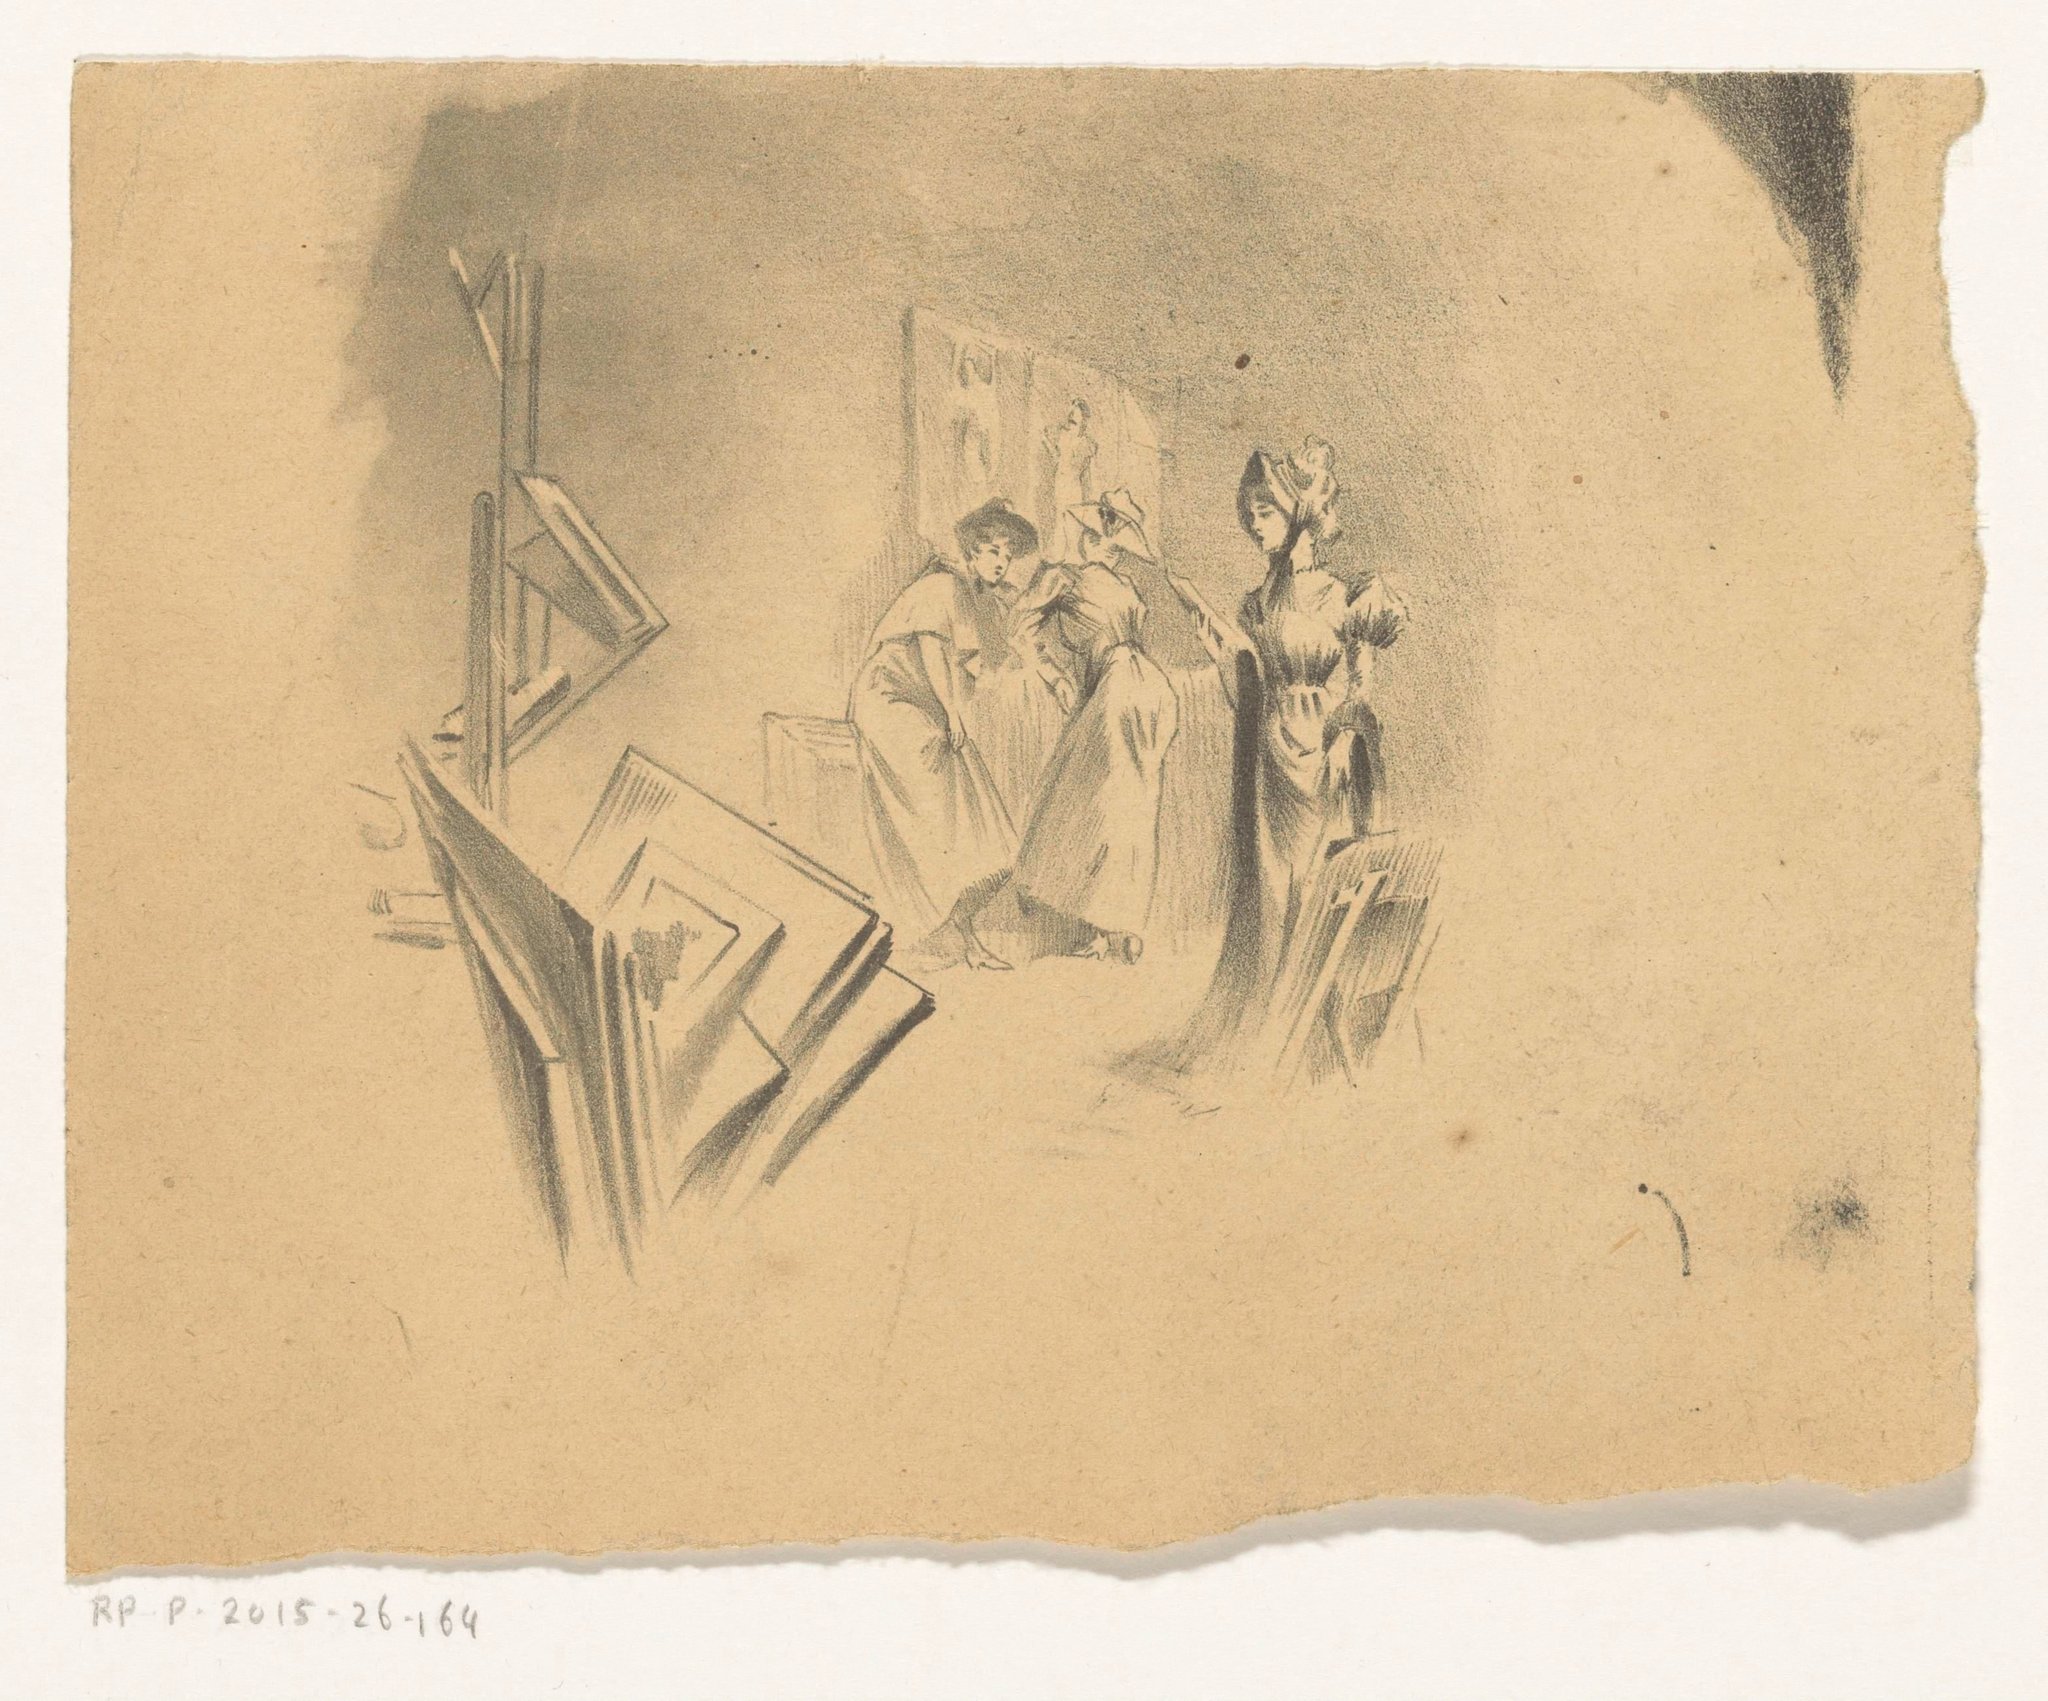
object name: print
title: Drie vrouwen bekijken prenten in een atelier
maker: henri patrice dillon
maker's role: print maker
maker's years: 1850-1909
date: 1860-1909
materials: paper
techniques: lithograph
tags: printing press, workshop, studio of the artist (in general), art collecting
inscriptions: collector's mark: Lugt 2228, collector's mark: Lugt 4779, stamp: ‘Dillon [in spiegelbeeld]’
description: Waarschijnlijk een fragment van een groter geheel.